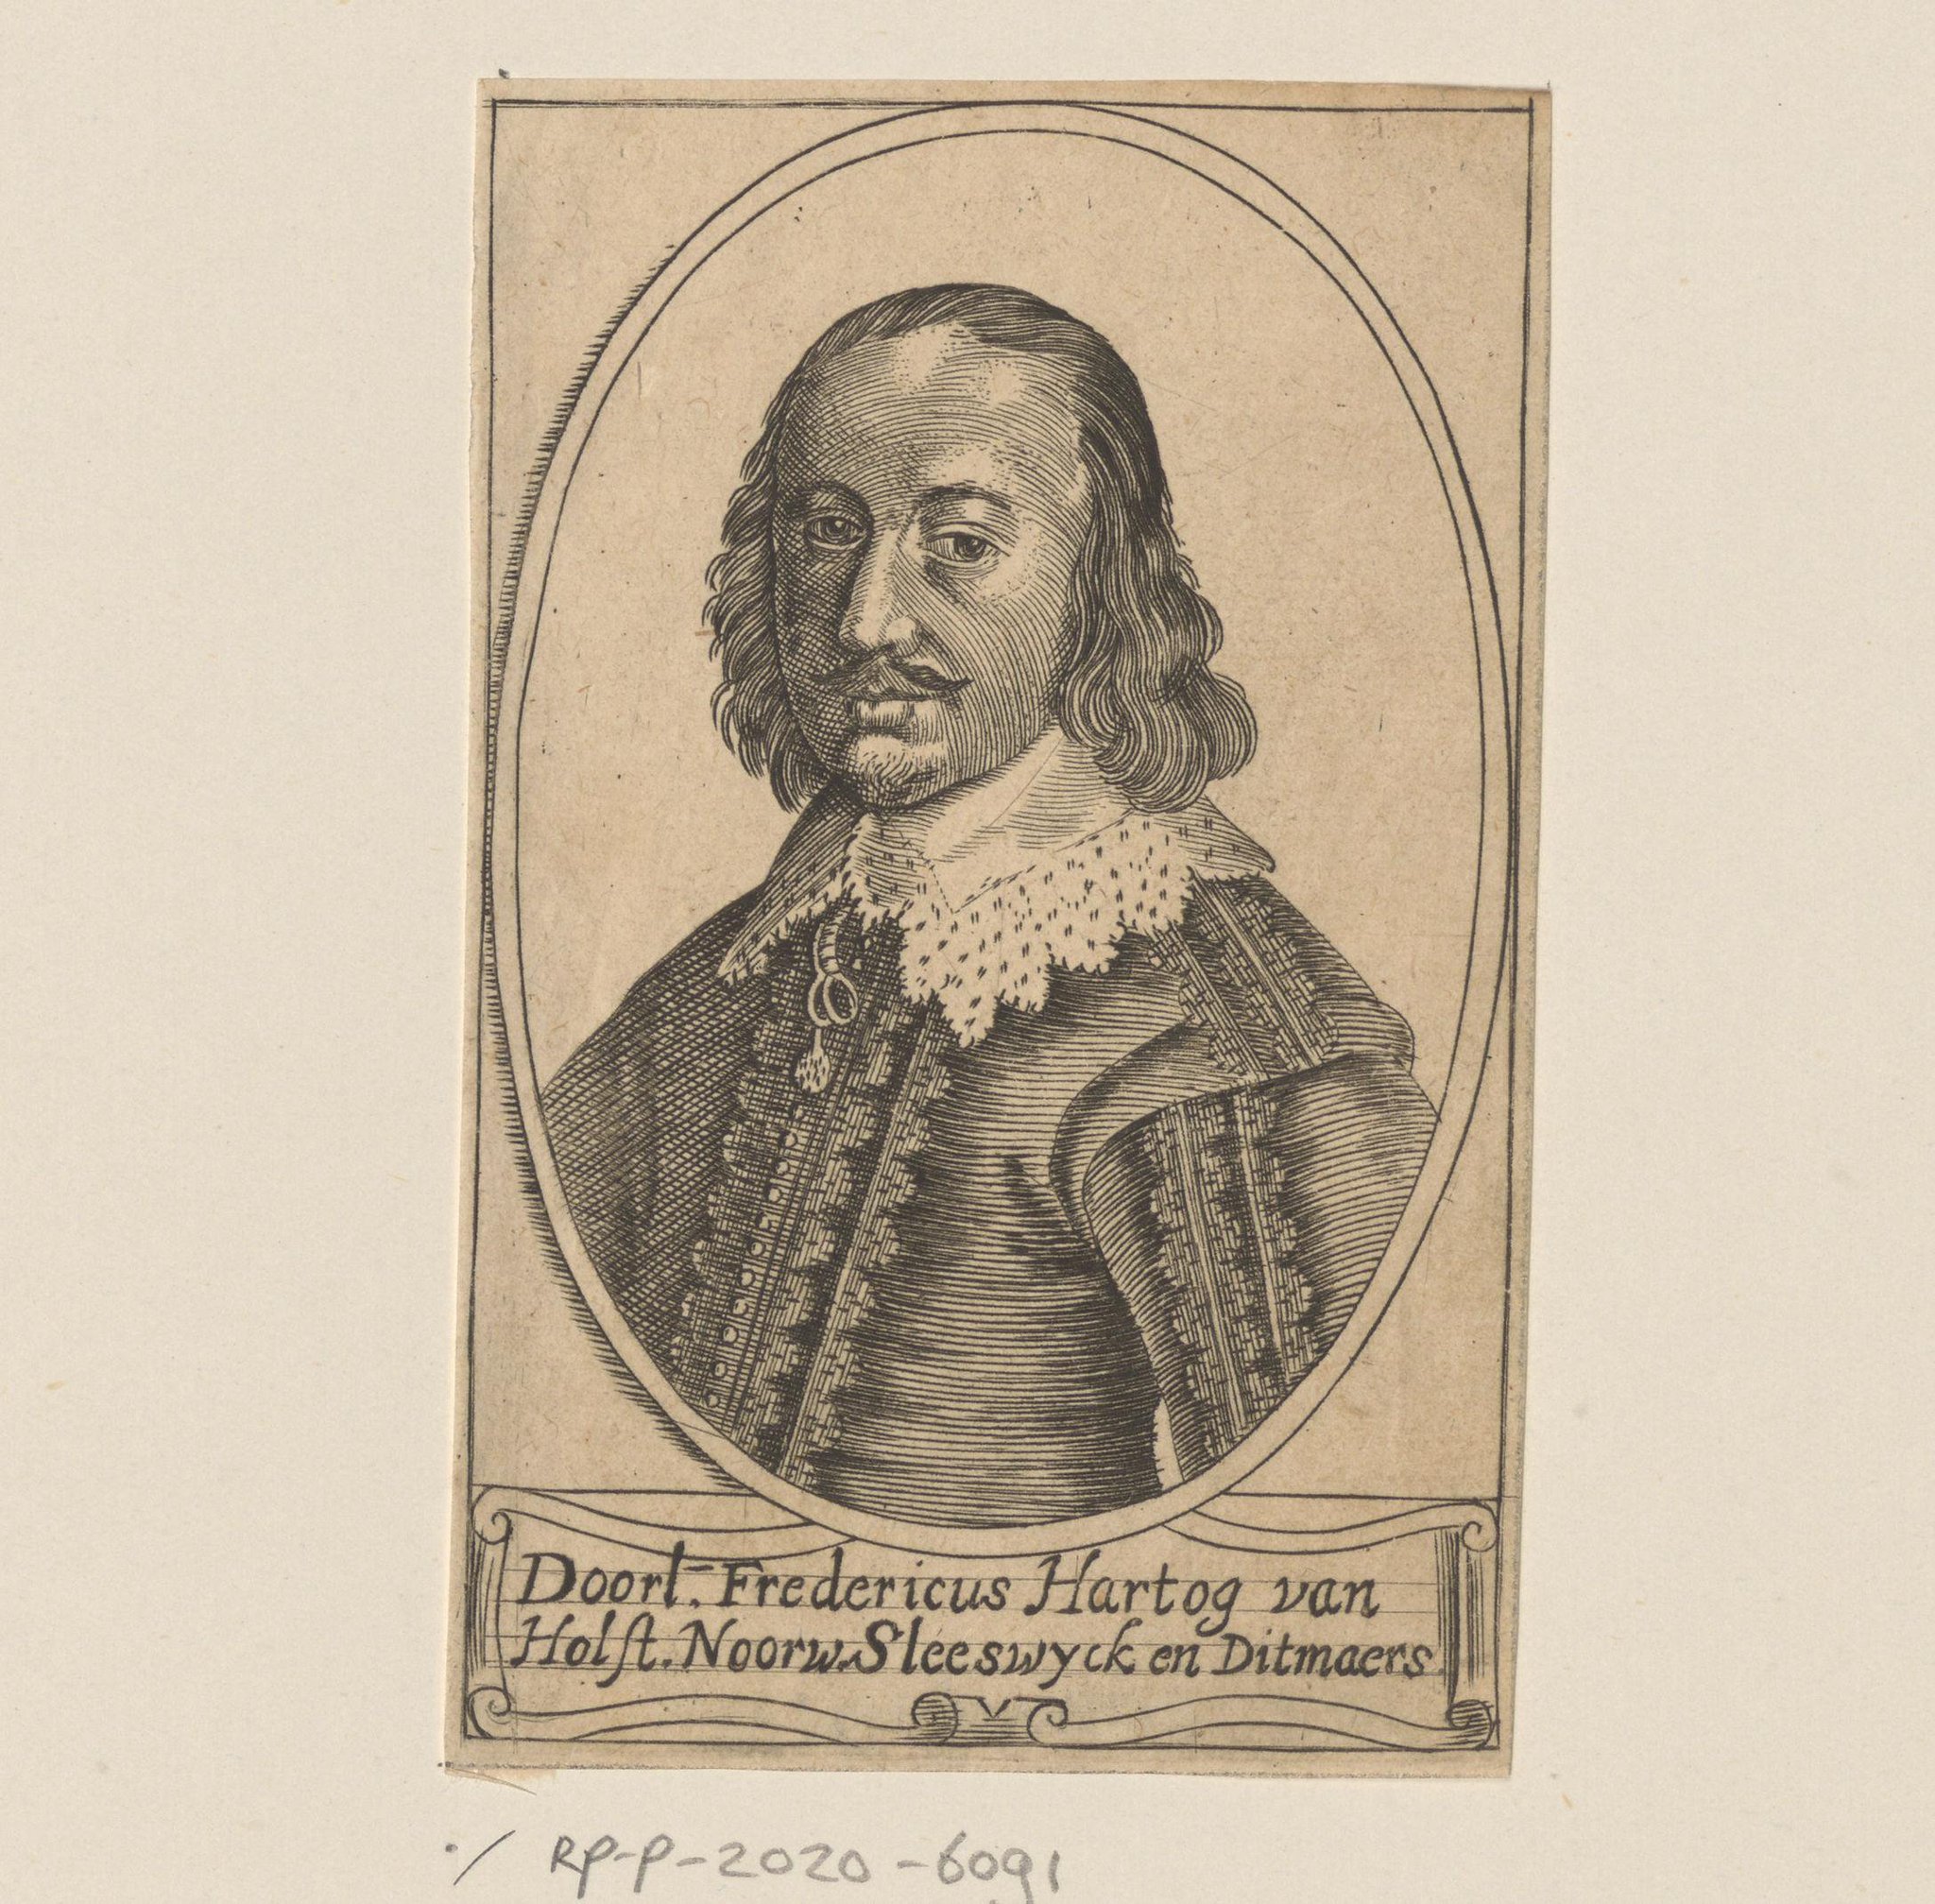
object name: book illustration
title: Portret van Frederik III van Sleeswijk-Holstein-Gottorp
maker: Anonymous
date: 1630-1700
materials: paper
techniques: engraving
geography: northern netherlands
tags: historical persons